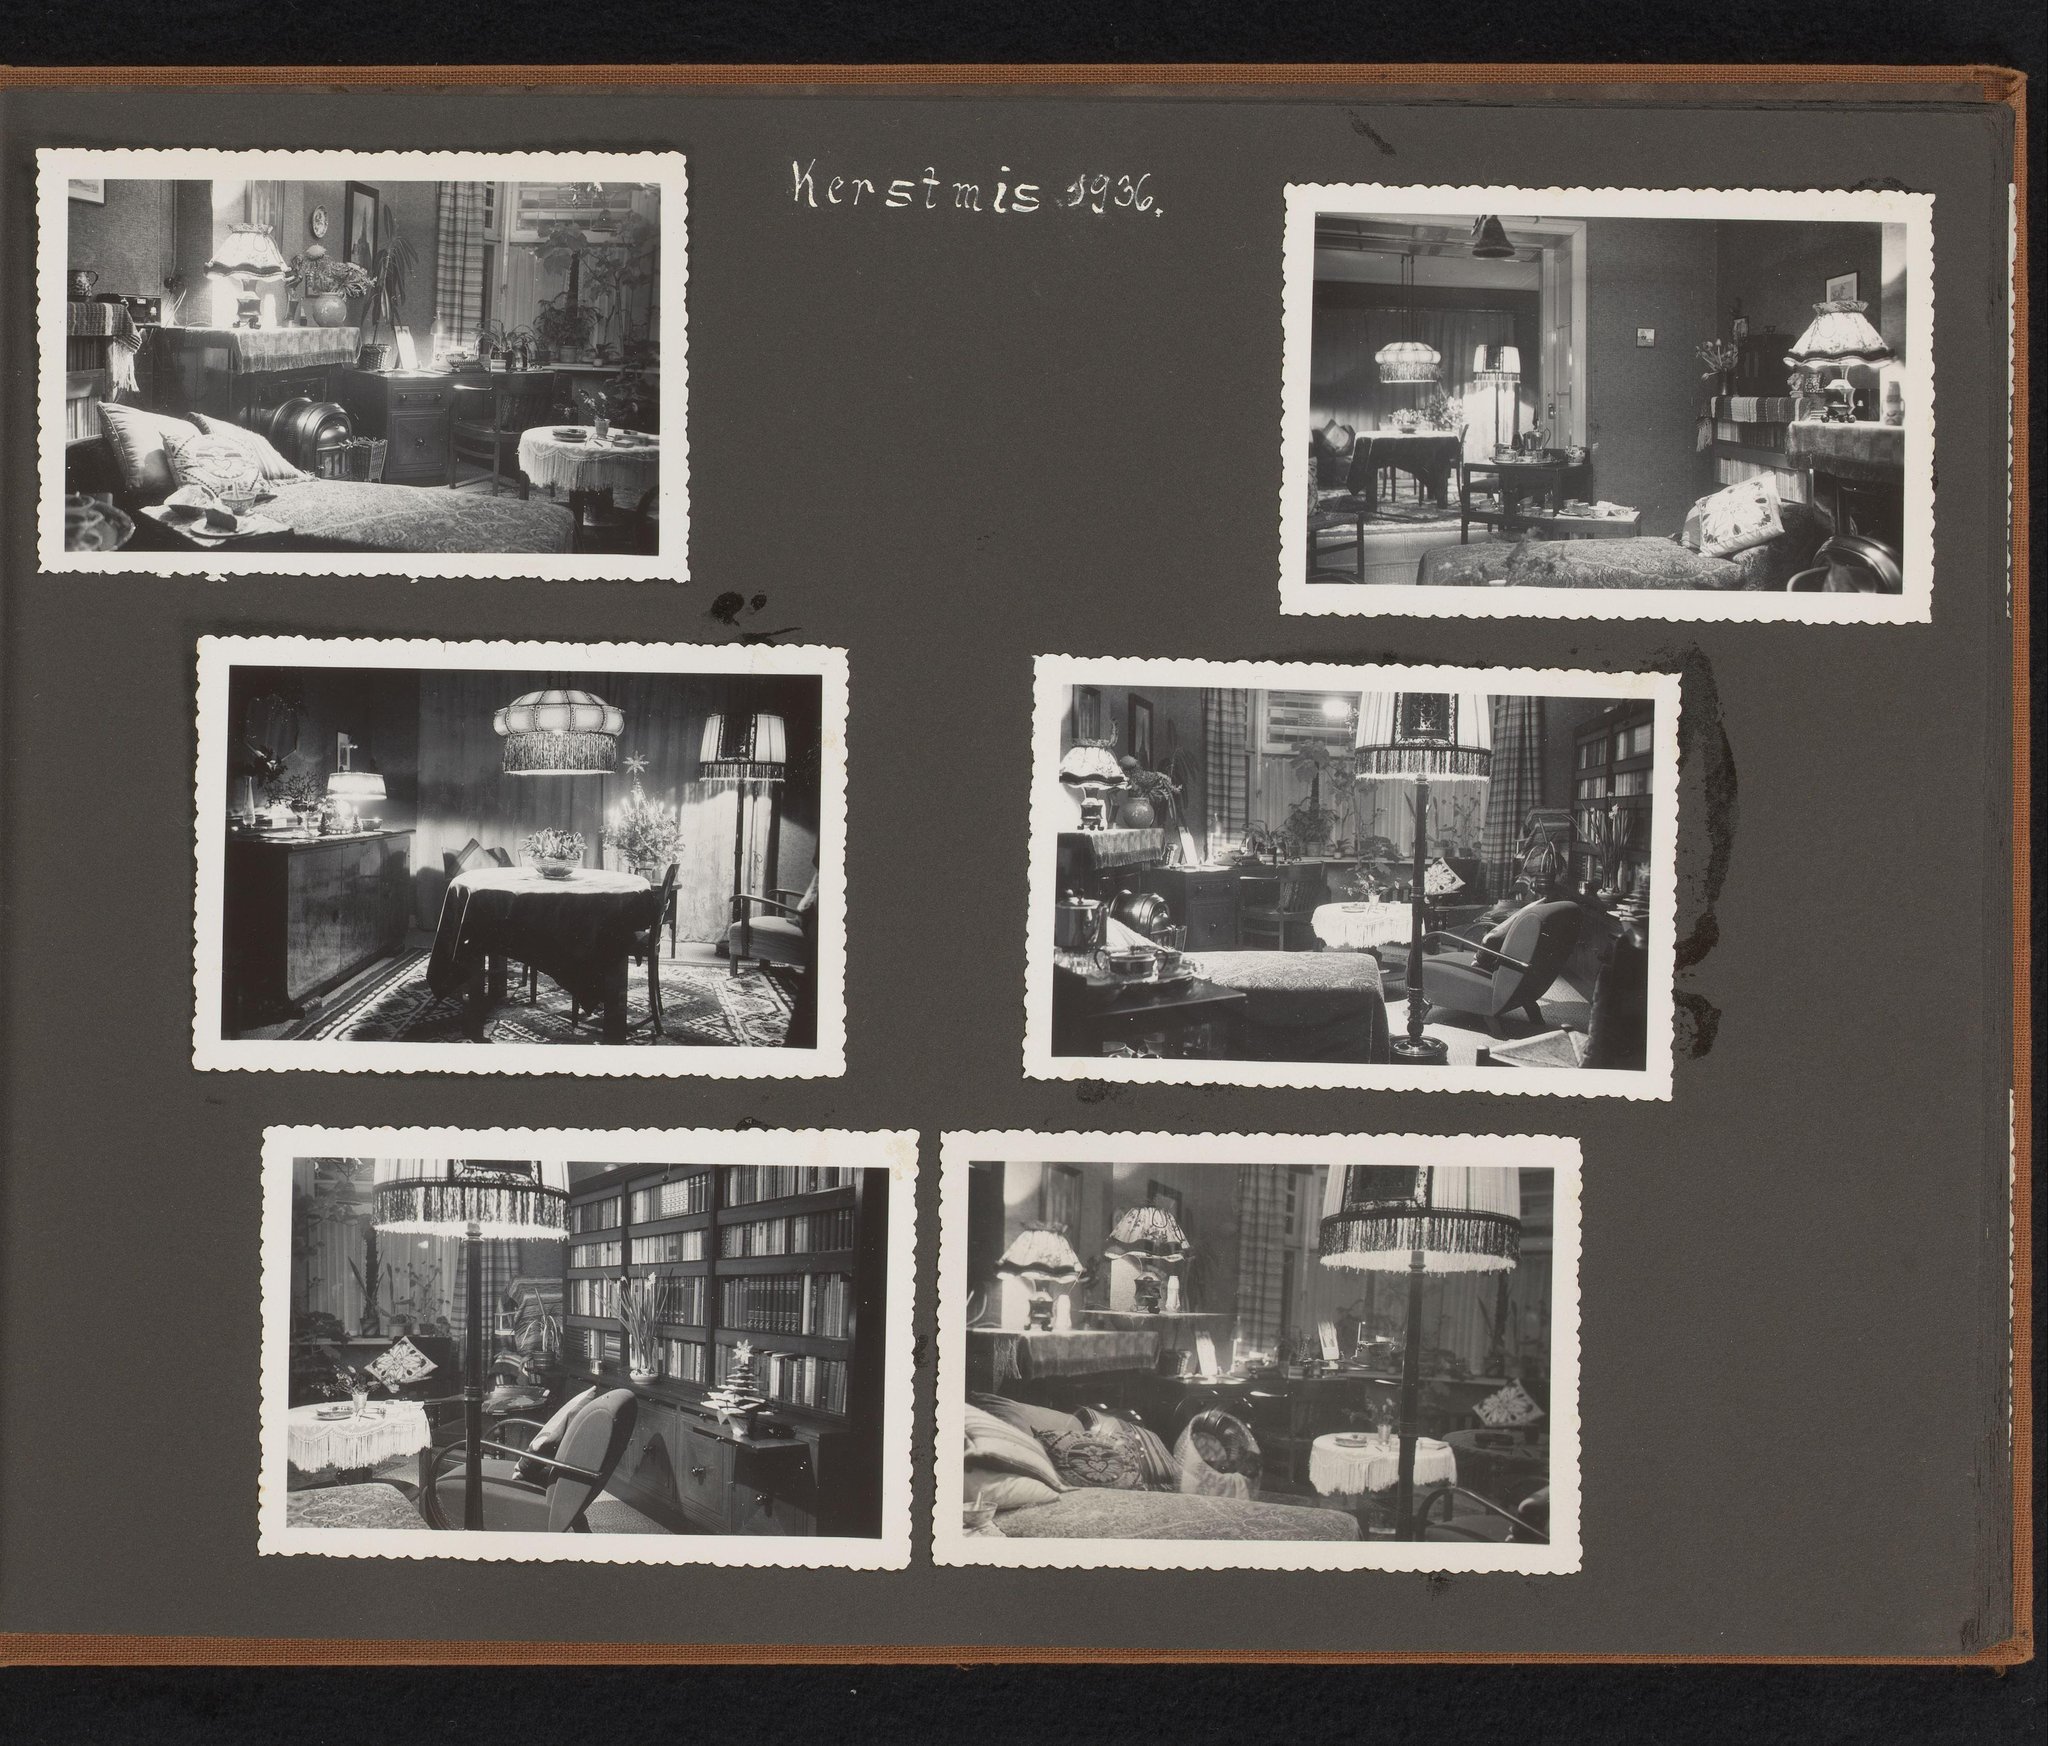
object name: album leaf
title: Interieur van Berti Hoppe en Herman Besselaar rond kerstmis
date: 1912-1936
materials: cardboard, paper, photographic support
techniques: gelatin silver print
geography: rotterdam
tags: christmas decorations, interior of the house, rotterdam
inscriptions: date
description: Zes foto's gemaakt rond kerstmis. Deze pagina maakt deel uit van een album.